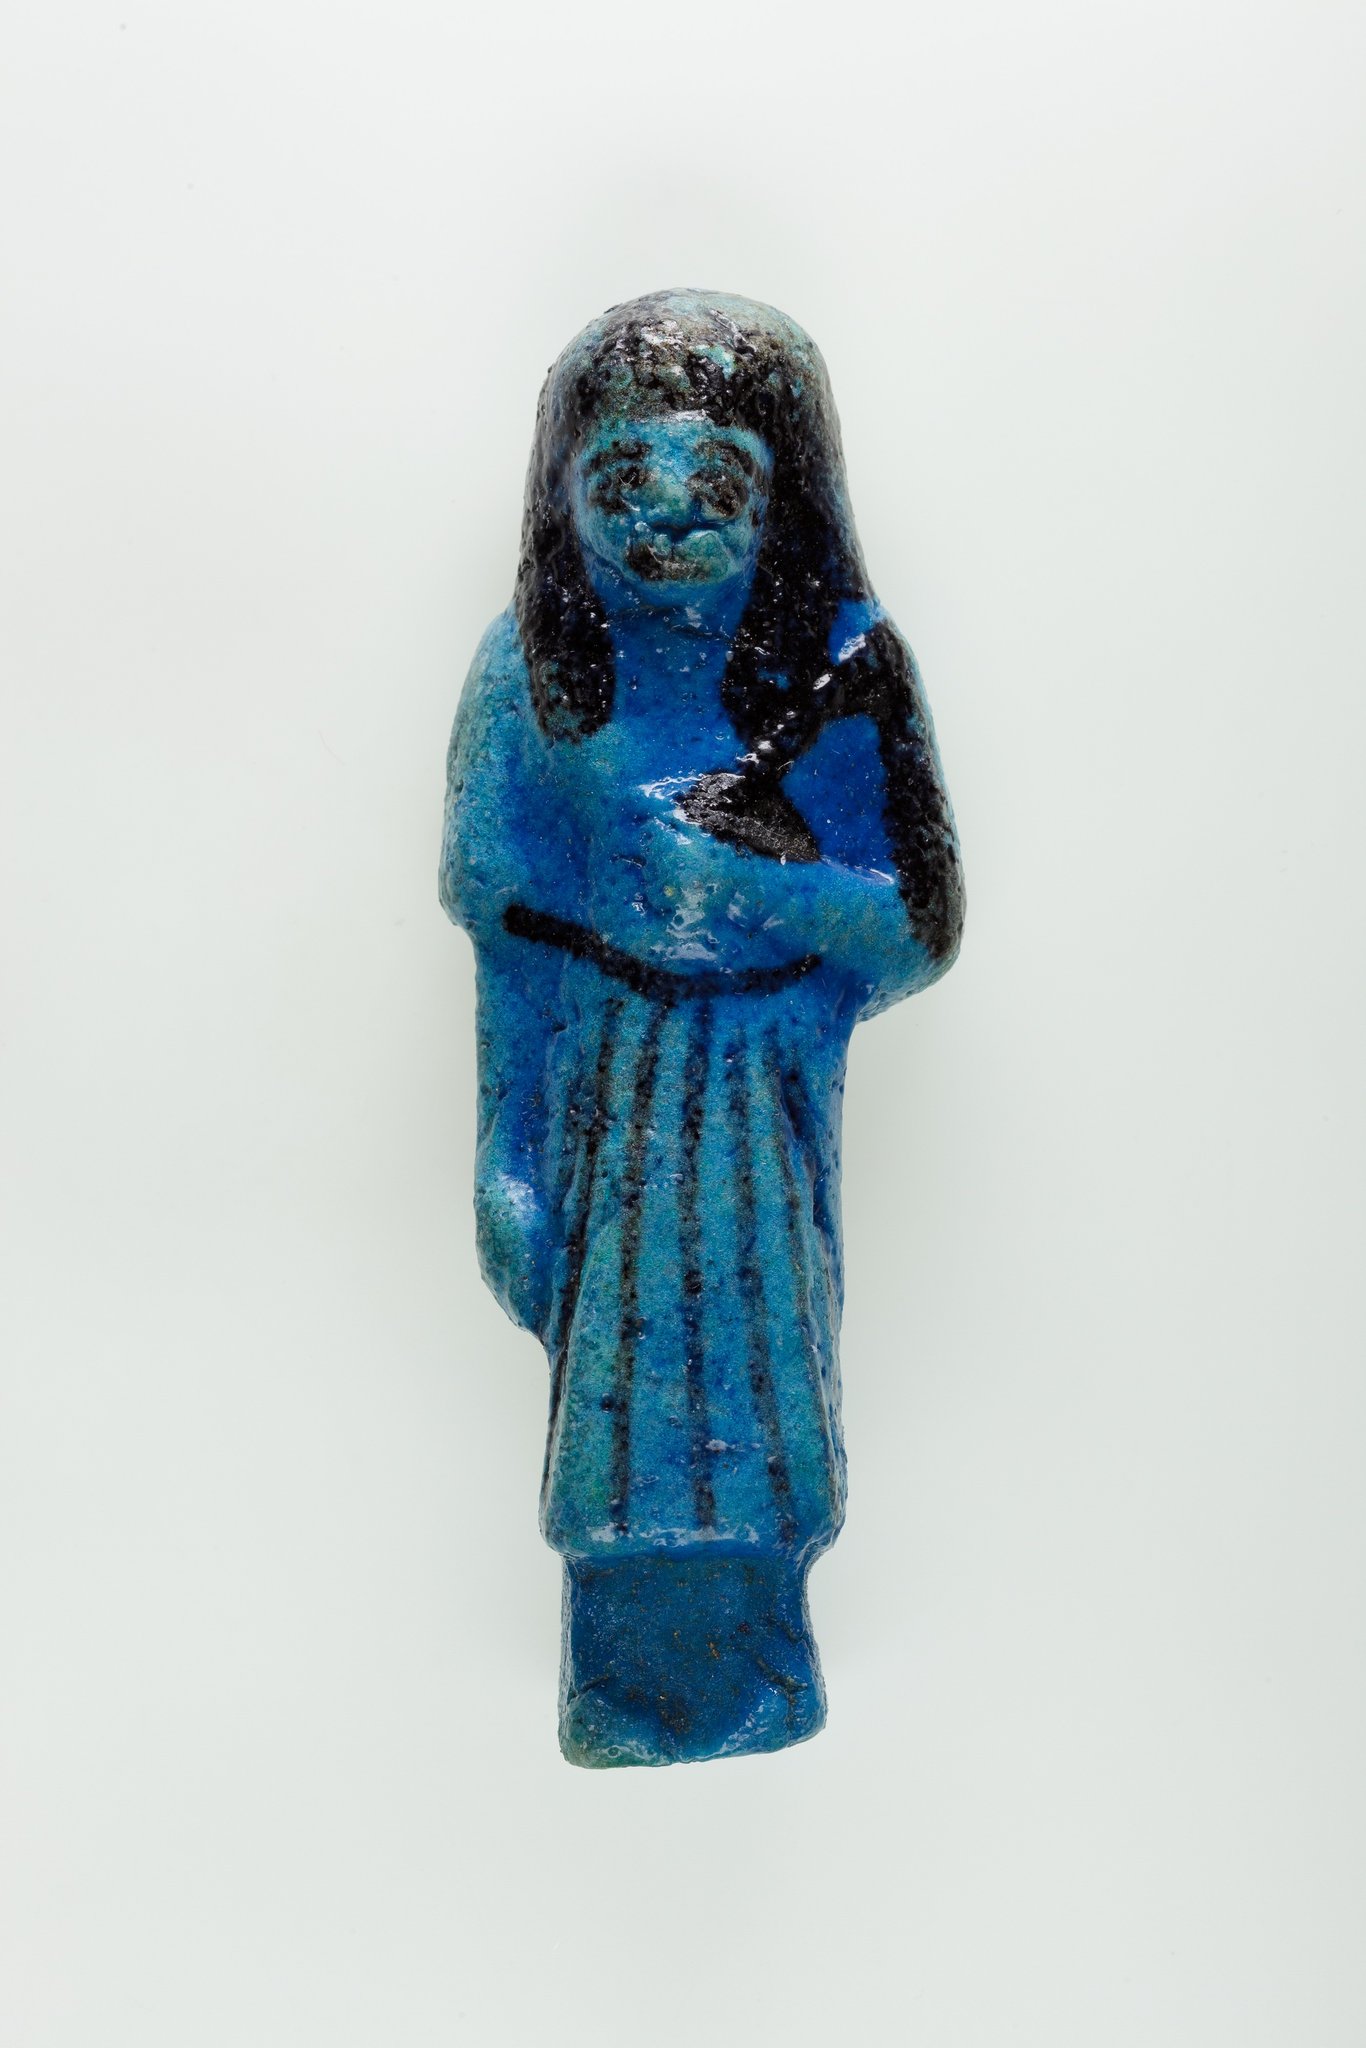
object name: shabti, overseer, nauny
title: Overseer Shabti of Nauny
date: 1050 BCE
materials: faience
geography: egypt